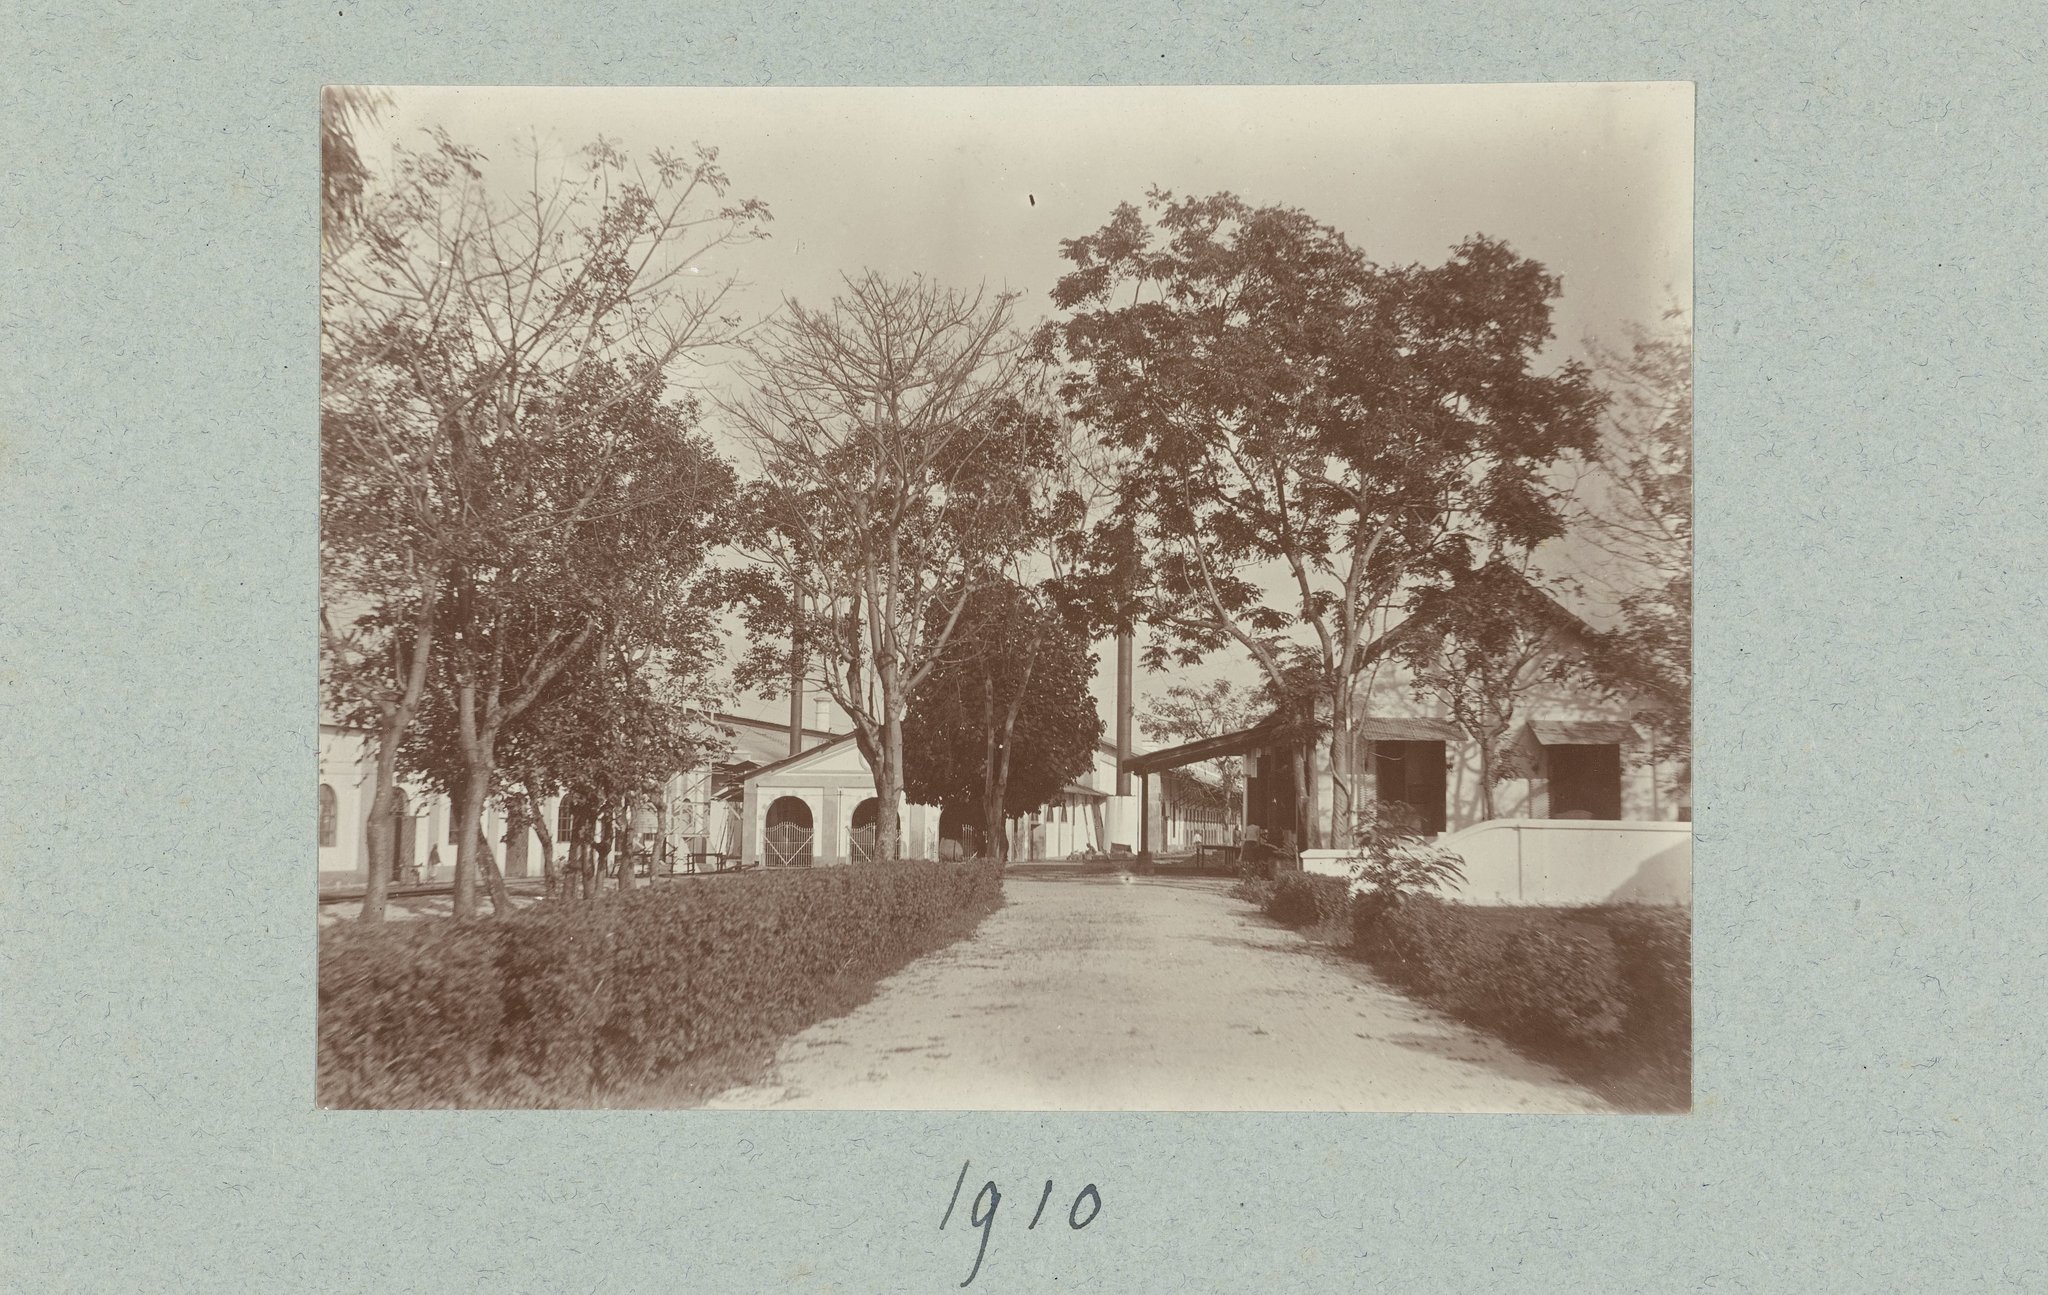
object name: photograph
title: 1910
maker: frits freerks fontein fz.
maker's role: fotograaf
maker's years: 1882-1928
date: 1910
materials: cardboard, paper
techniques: gelatin silver print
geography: madura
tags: madura